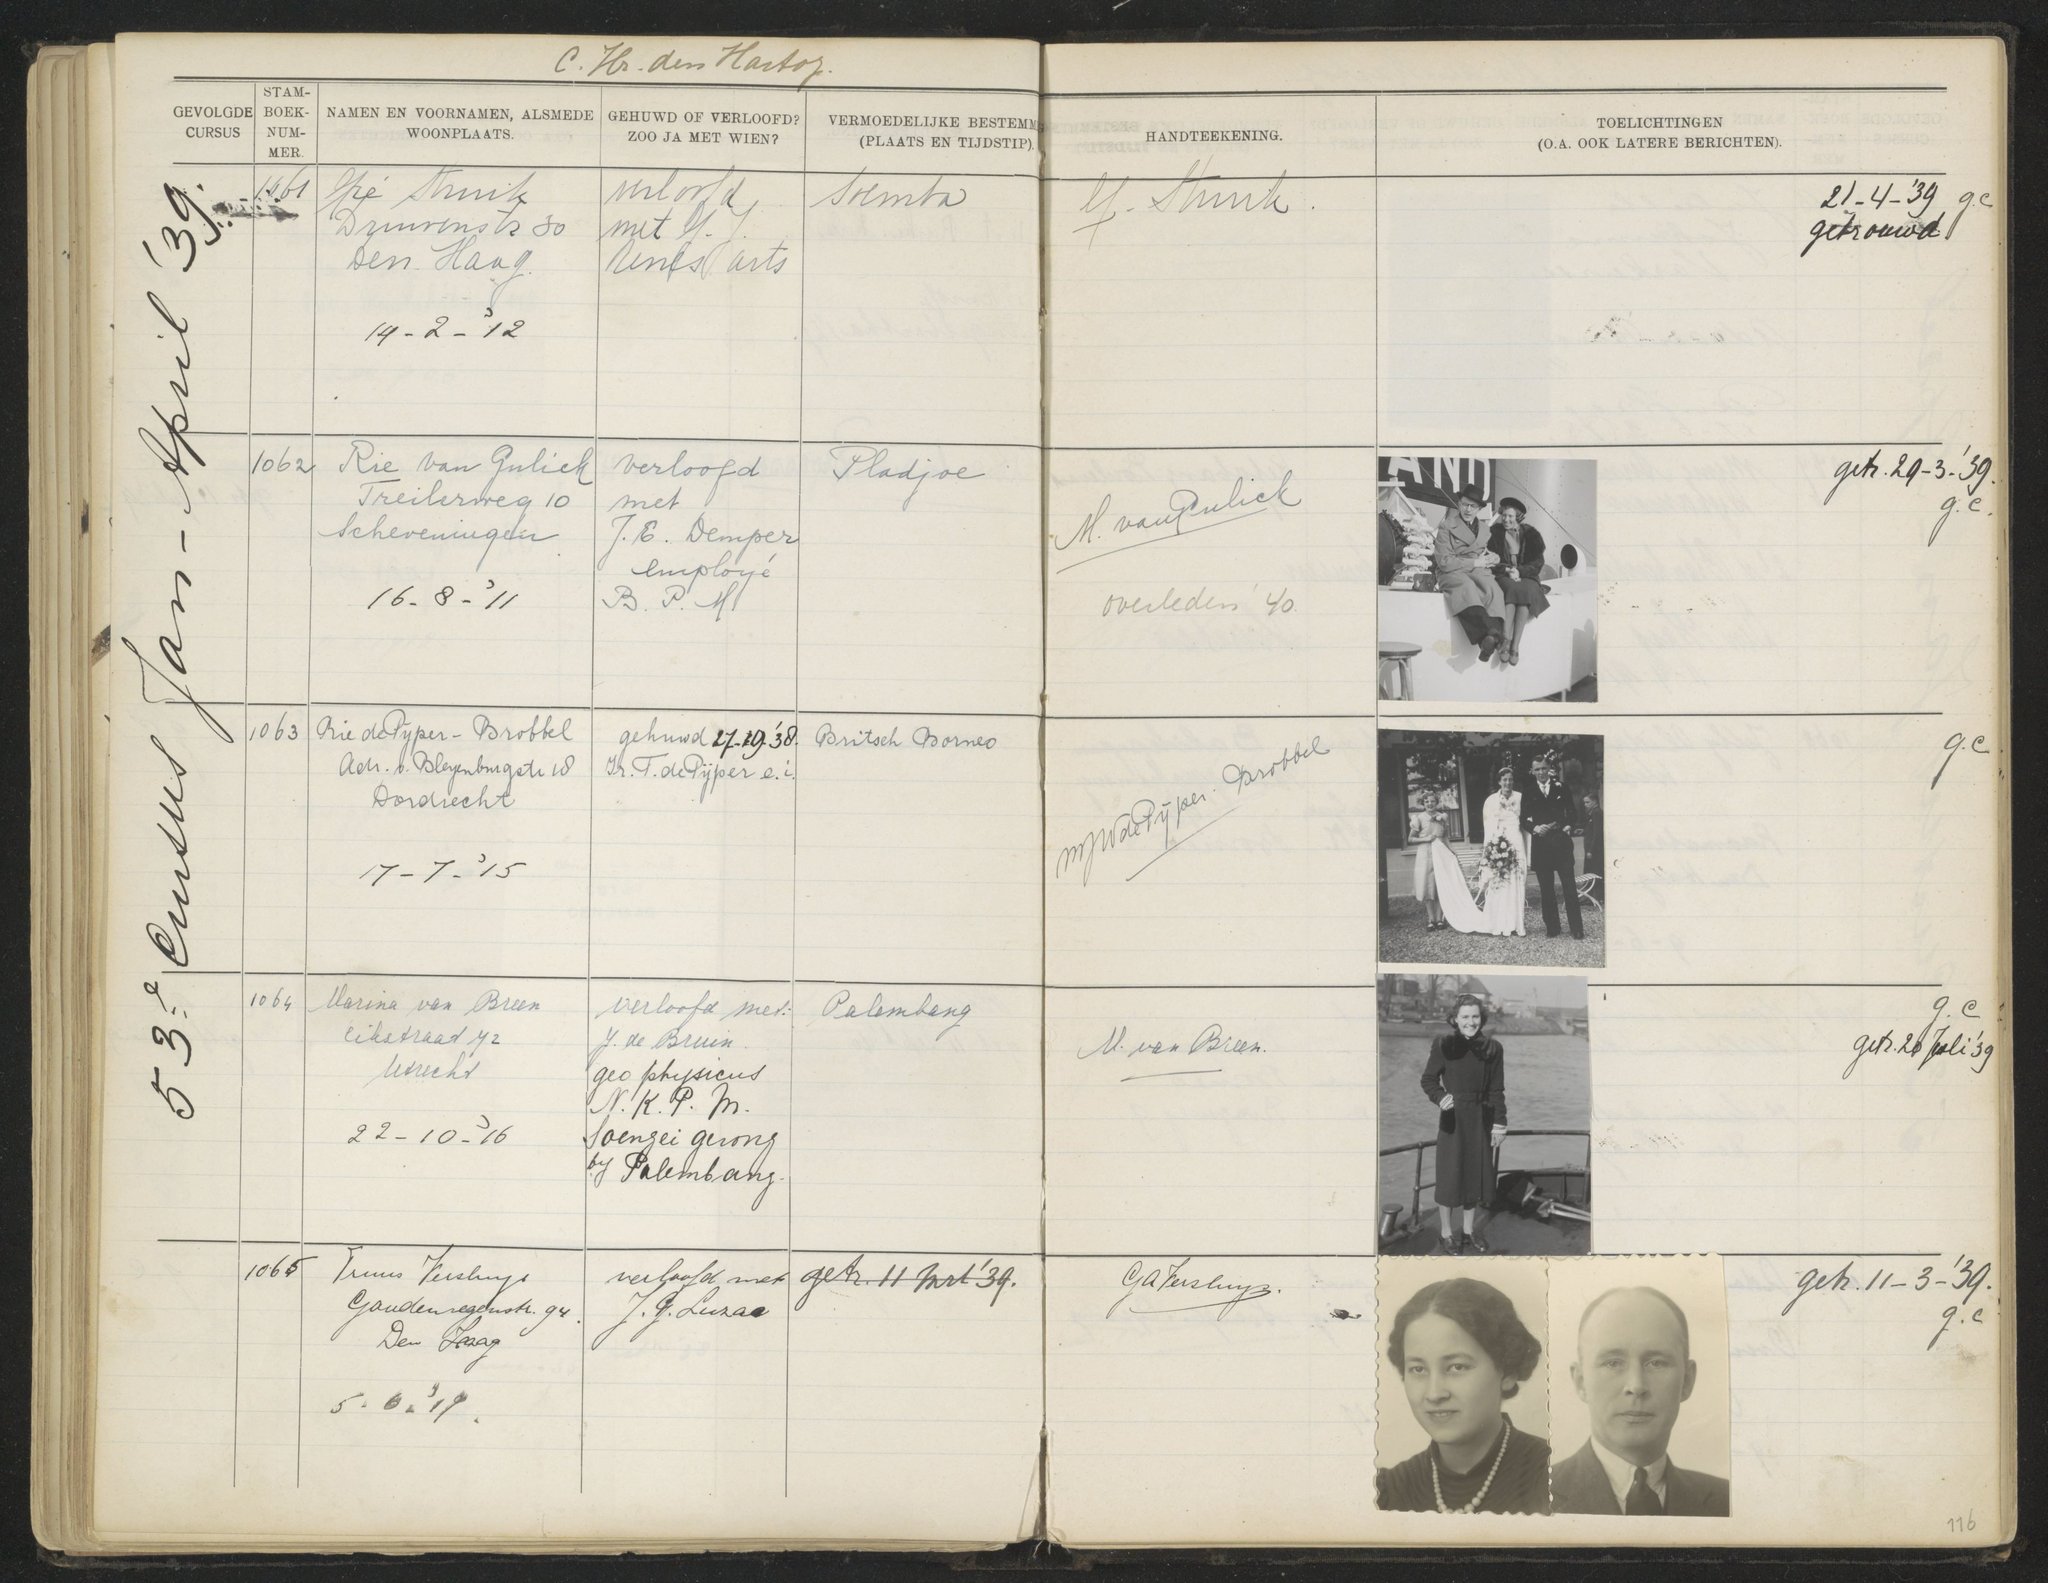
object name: photograph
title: Blad 116 uit Stamboek van de leerlingen der Koloniale School voor Meisjes en Vrouwen te 's-Gravenhage deel II (1930-1949)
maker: Anonymous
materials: paper, photographic support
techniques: photography, printing, writing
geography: the hague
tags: further education (+ pupil), further education, the hague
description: Twee pagina's met gegevens van de deelnemers aan de 53e driemaandelijkse cursus van januari tot april 1939, stamboeknummers 1061 tot en met 1065. Onderdeel van Stamboek van de leerlingen der Koloniale School voor Meisjes en Vrouwen te 's-Gravenhage deel II (1930-1949).